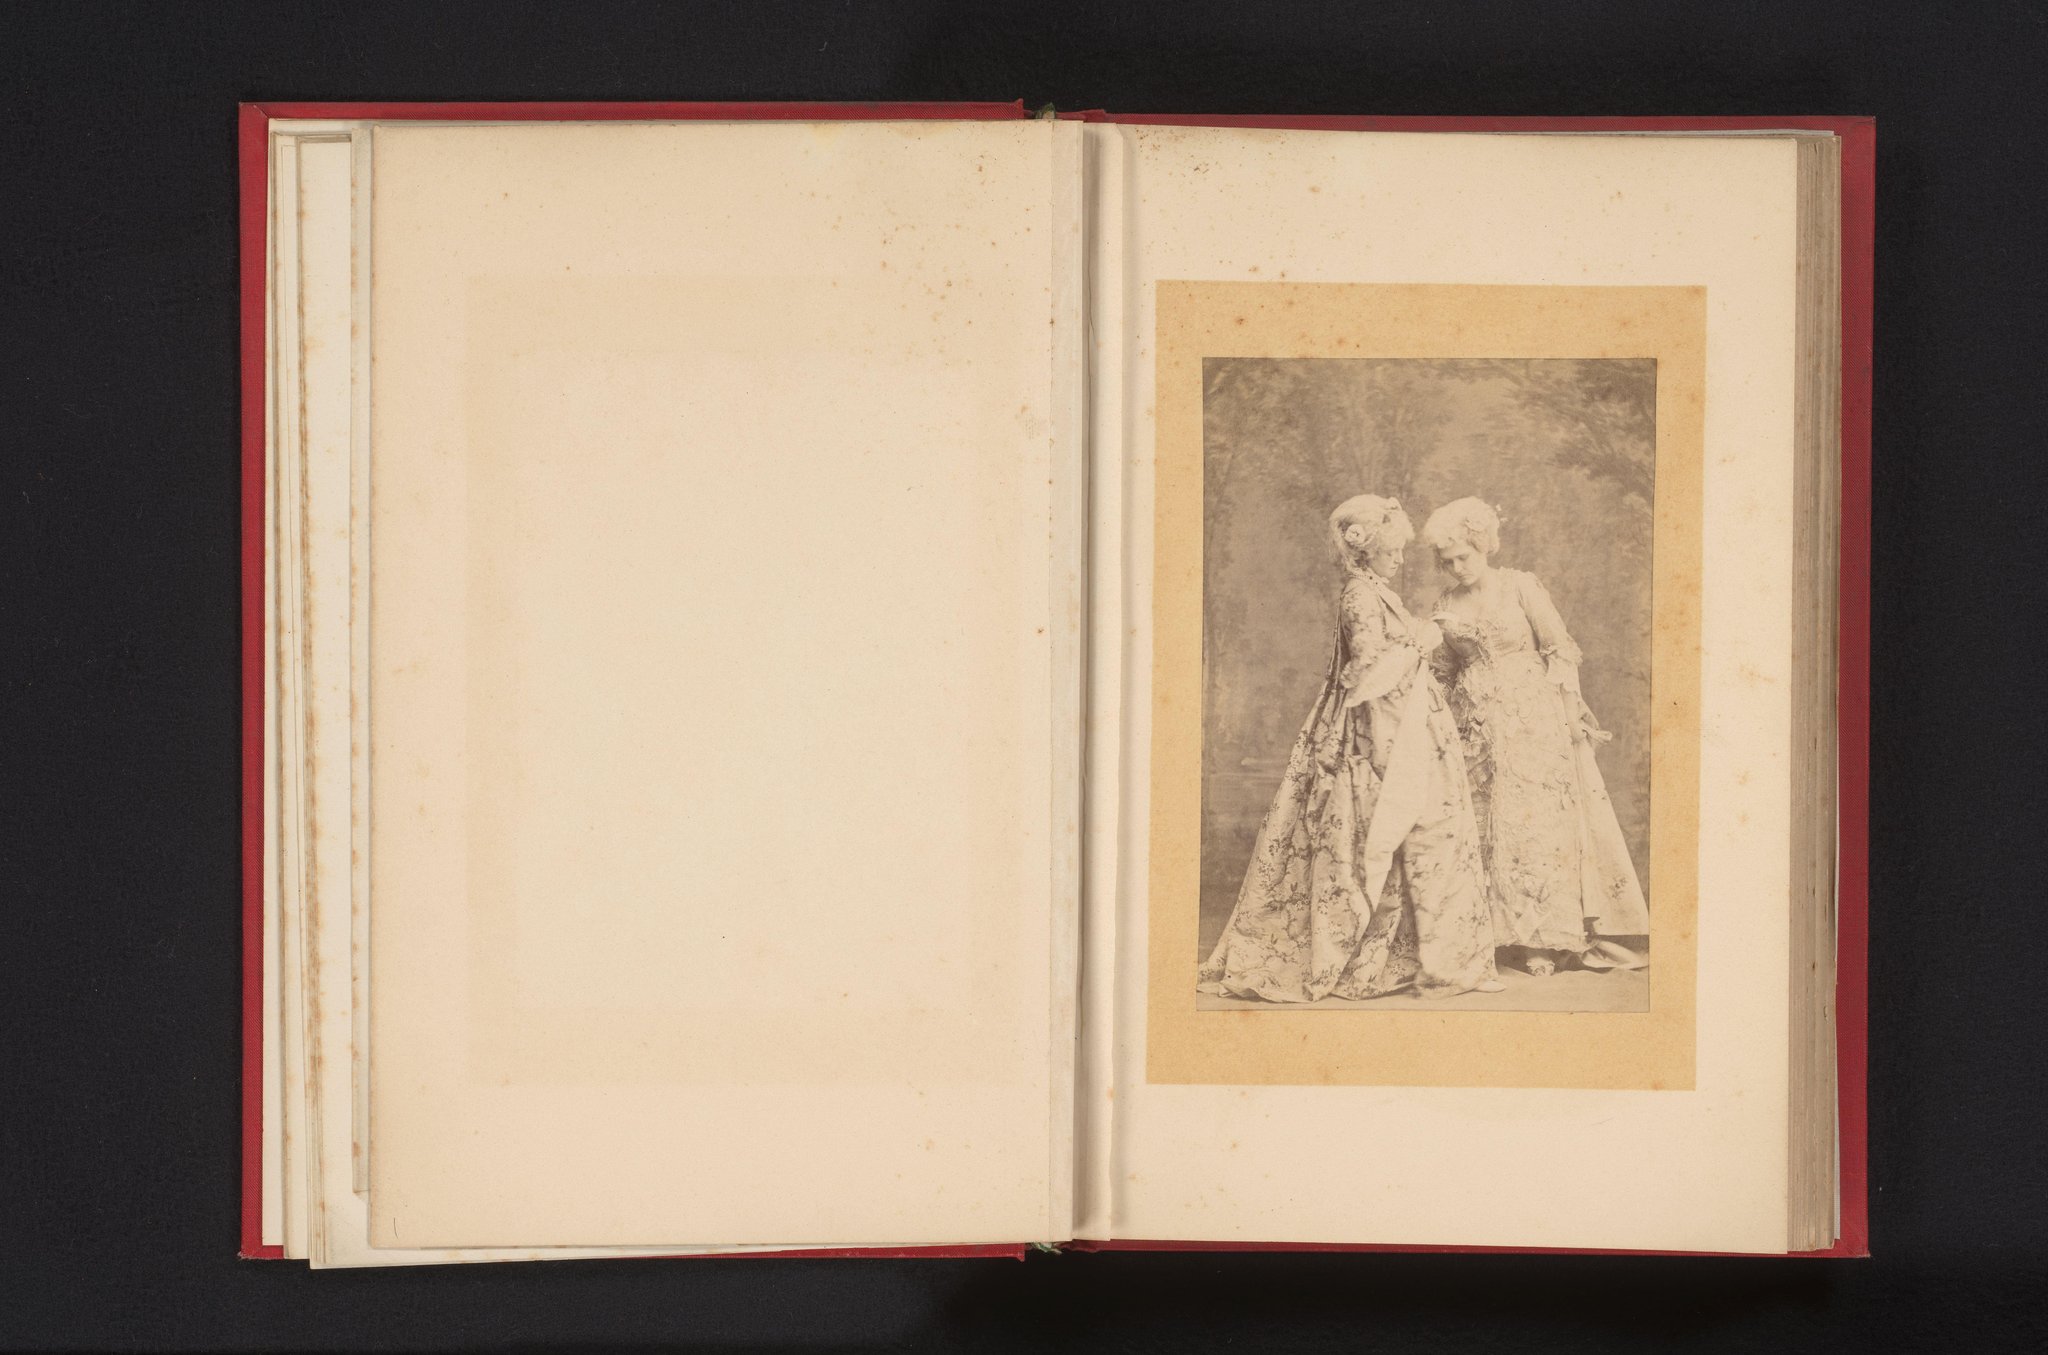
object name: page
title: Twee onbekende vrouwen in kleding uit de achttiende eeuw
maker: Anonymous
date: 1873-1878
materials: photographic support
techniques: albumen print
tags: historical persons, wig, clothes, costume